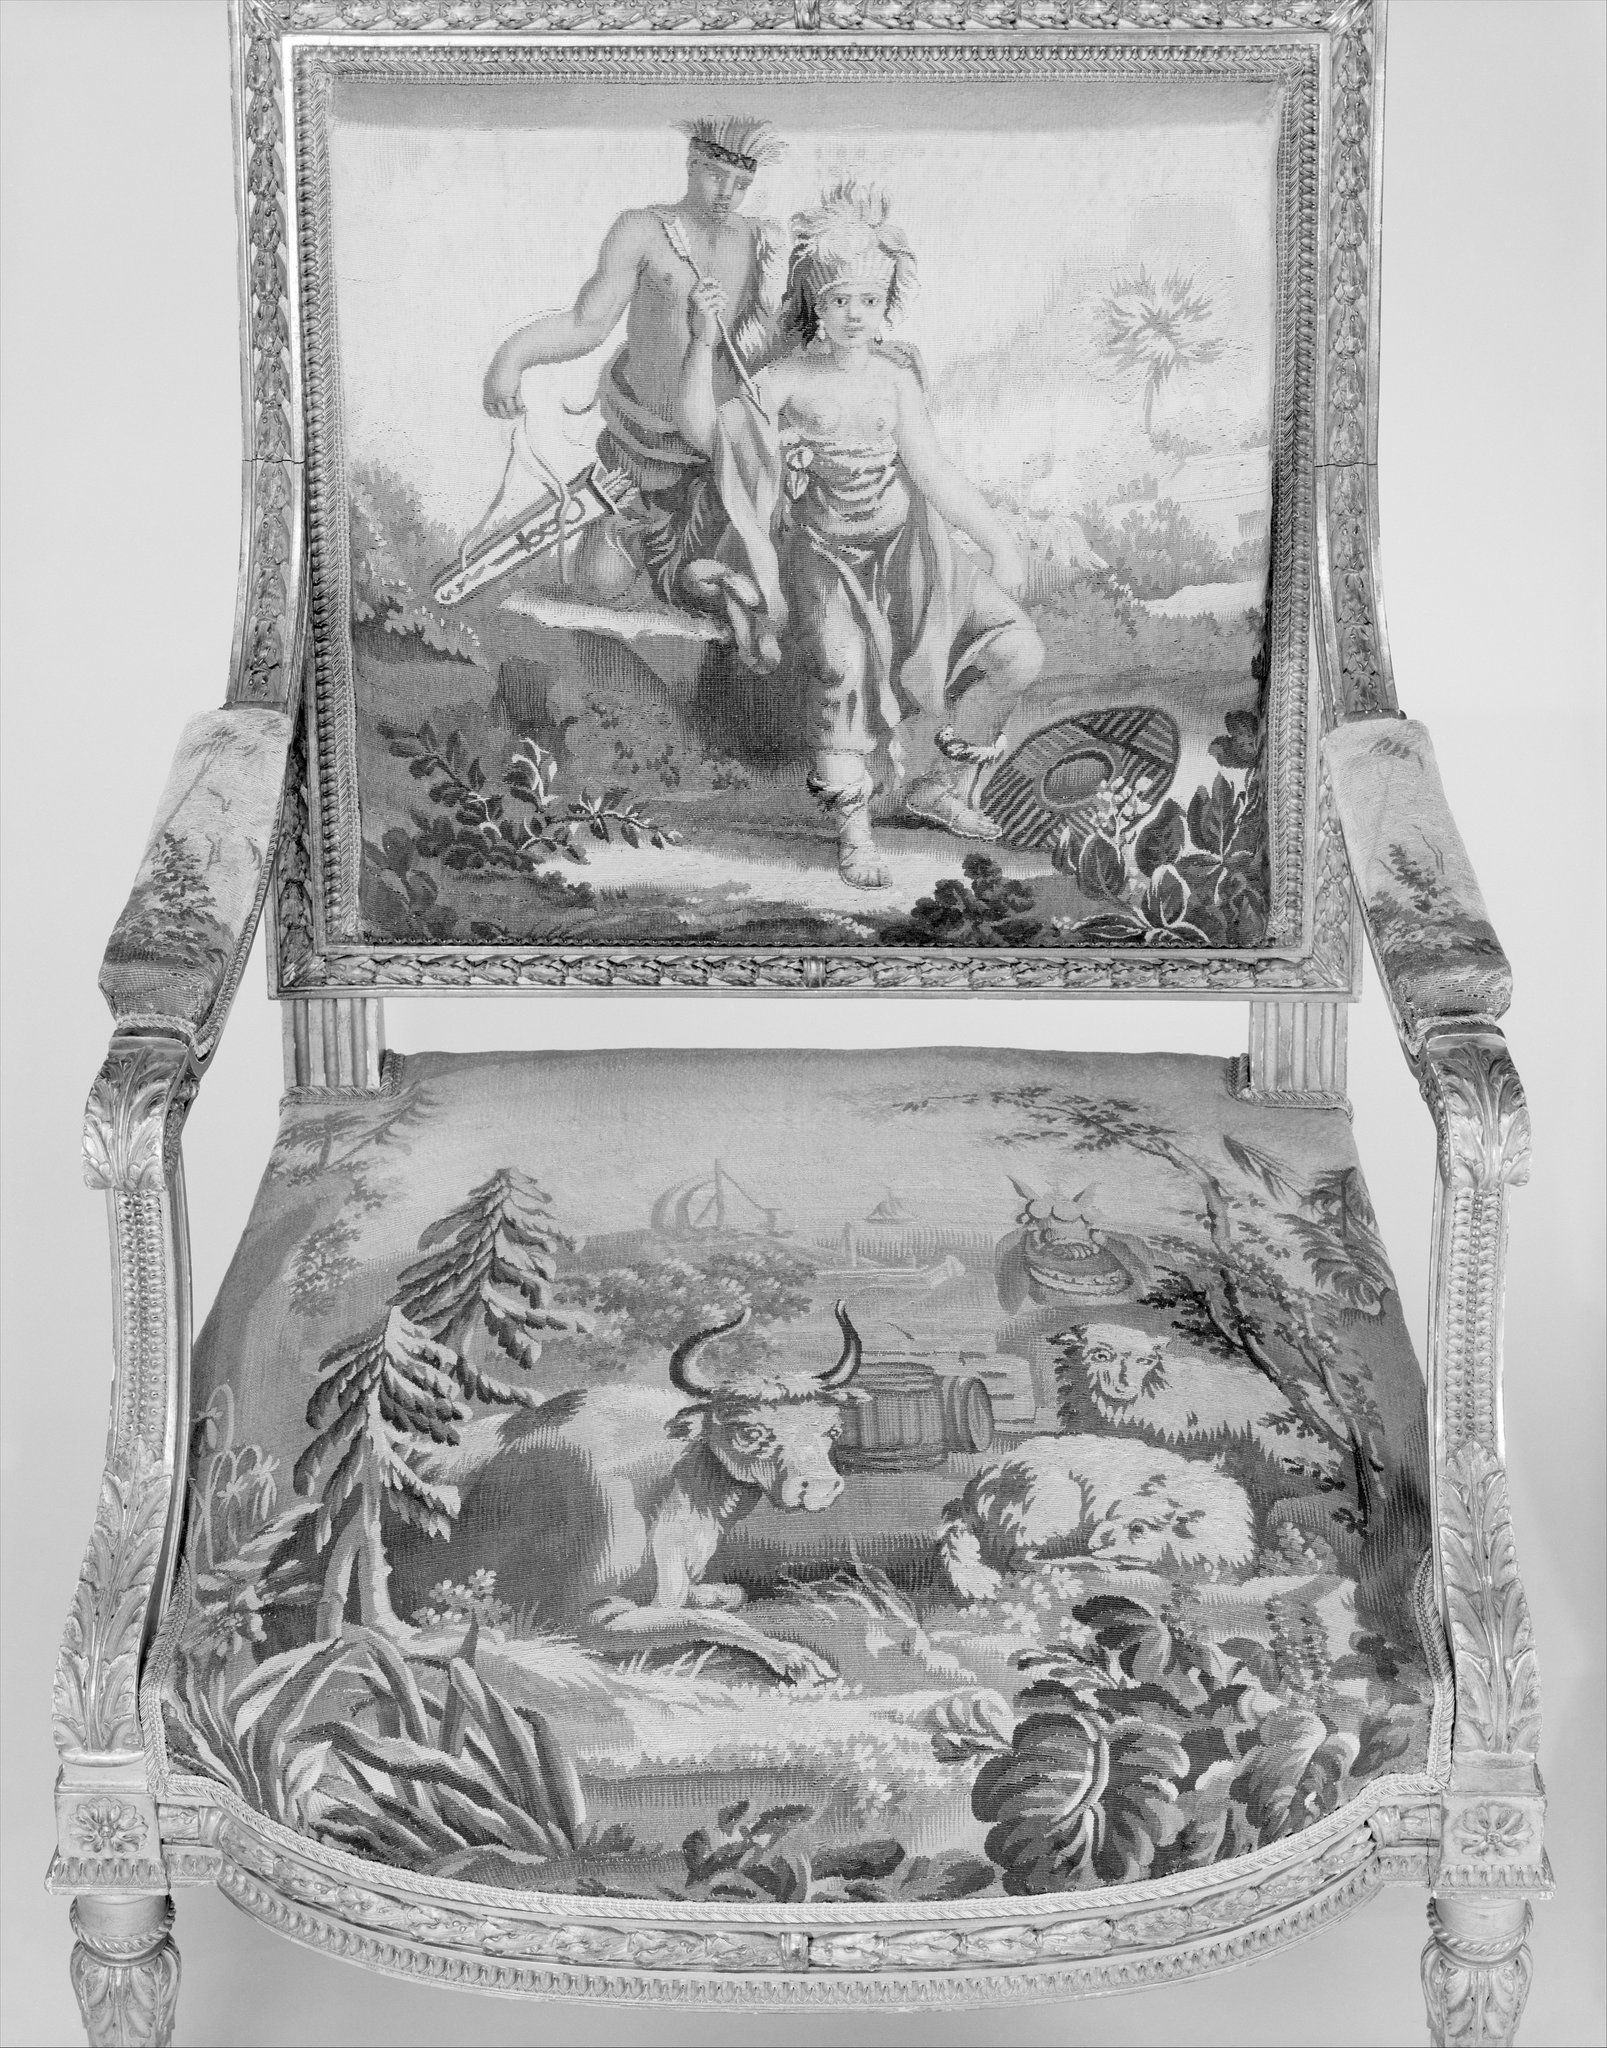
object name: armchair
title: America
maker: beauvais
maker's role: manufactory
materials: silk, wood, wool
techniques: carving, gilding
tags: men,women,sheep,ox